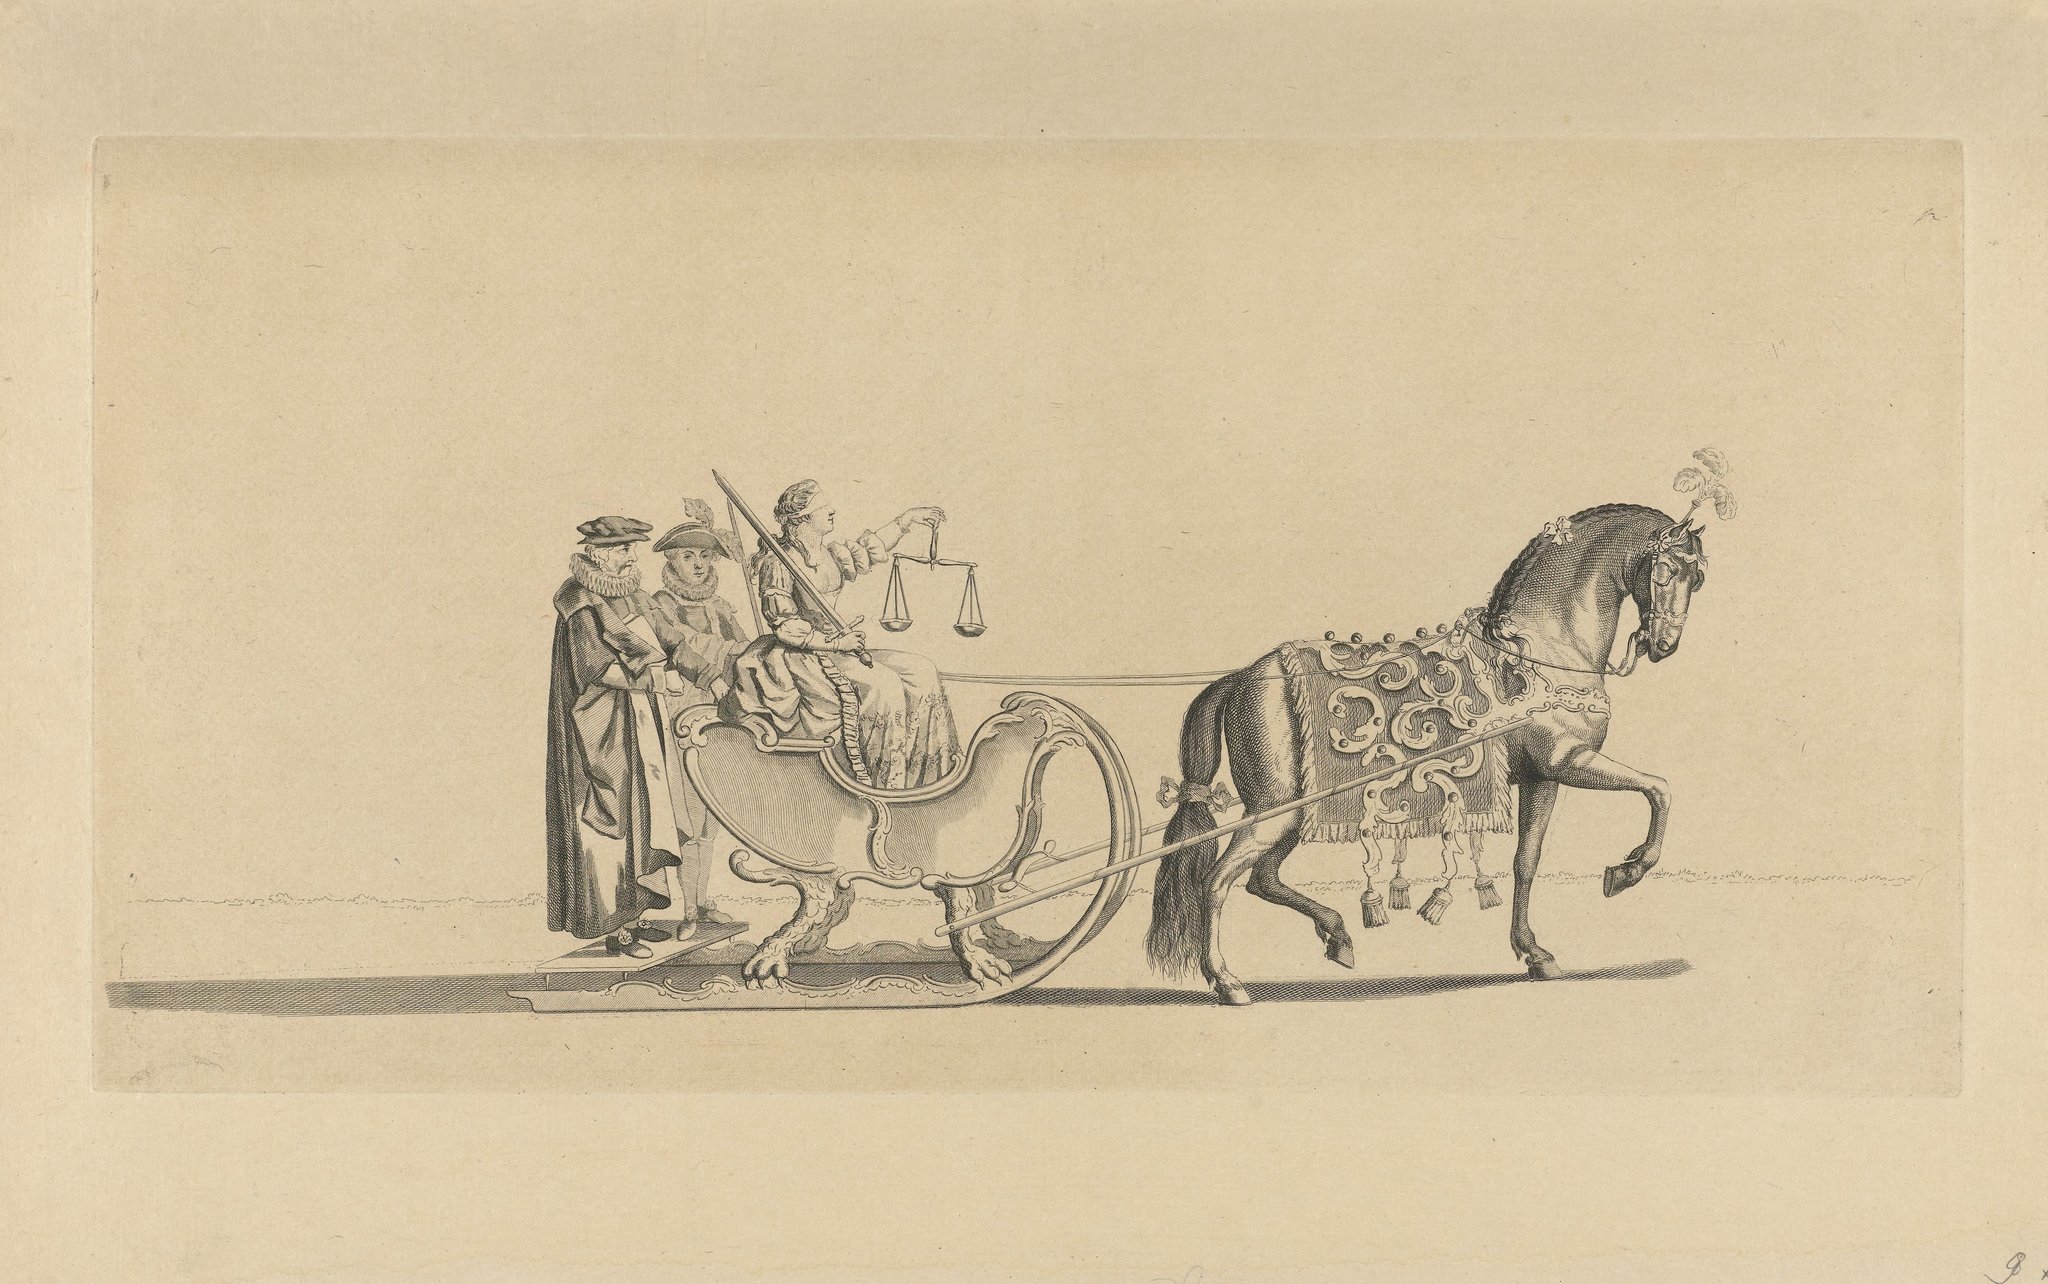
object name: print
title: Sledevaart van het Leidse genootschap Veniam Pro Laude in 1776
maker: nicolaas van der worm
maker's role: draughtsman, print maker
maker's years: 1757-1828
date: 1776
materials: paper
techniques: engraving, etching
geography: northern netherlands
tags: justice, 'justitia'; 'giustitia divina' (ripa) ~ one of the four cardinal virtues, sledge, sleigh (winter sports), commemoration of the founding of a university, leiden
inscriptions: collector's mark: Lugt 240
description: De negende slede in de optocht. Een slede met de personificatie van de Rechtvaardigheid, getrokken door een paard. Onderdeel van een reeks van twaalf platen (vóór het nummer en op ander papier) van de sledevaart op 24 januari 1776 georganiseerd door het Leidse genootschap Veniam Pro Laude bij gelegenheid van het Tweede Eeuwfeest van het Leids Ontzet (3 oktober 1574) en de oprichting van de Universiteit van Leiden (8 februari 1575).